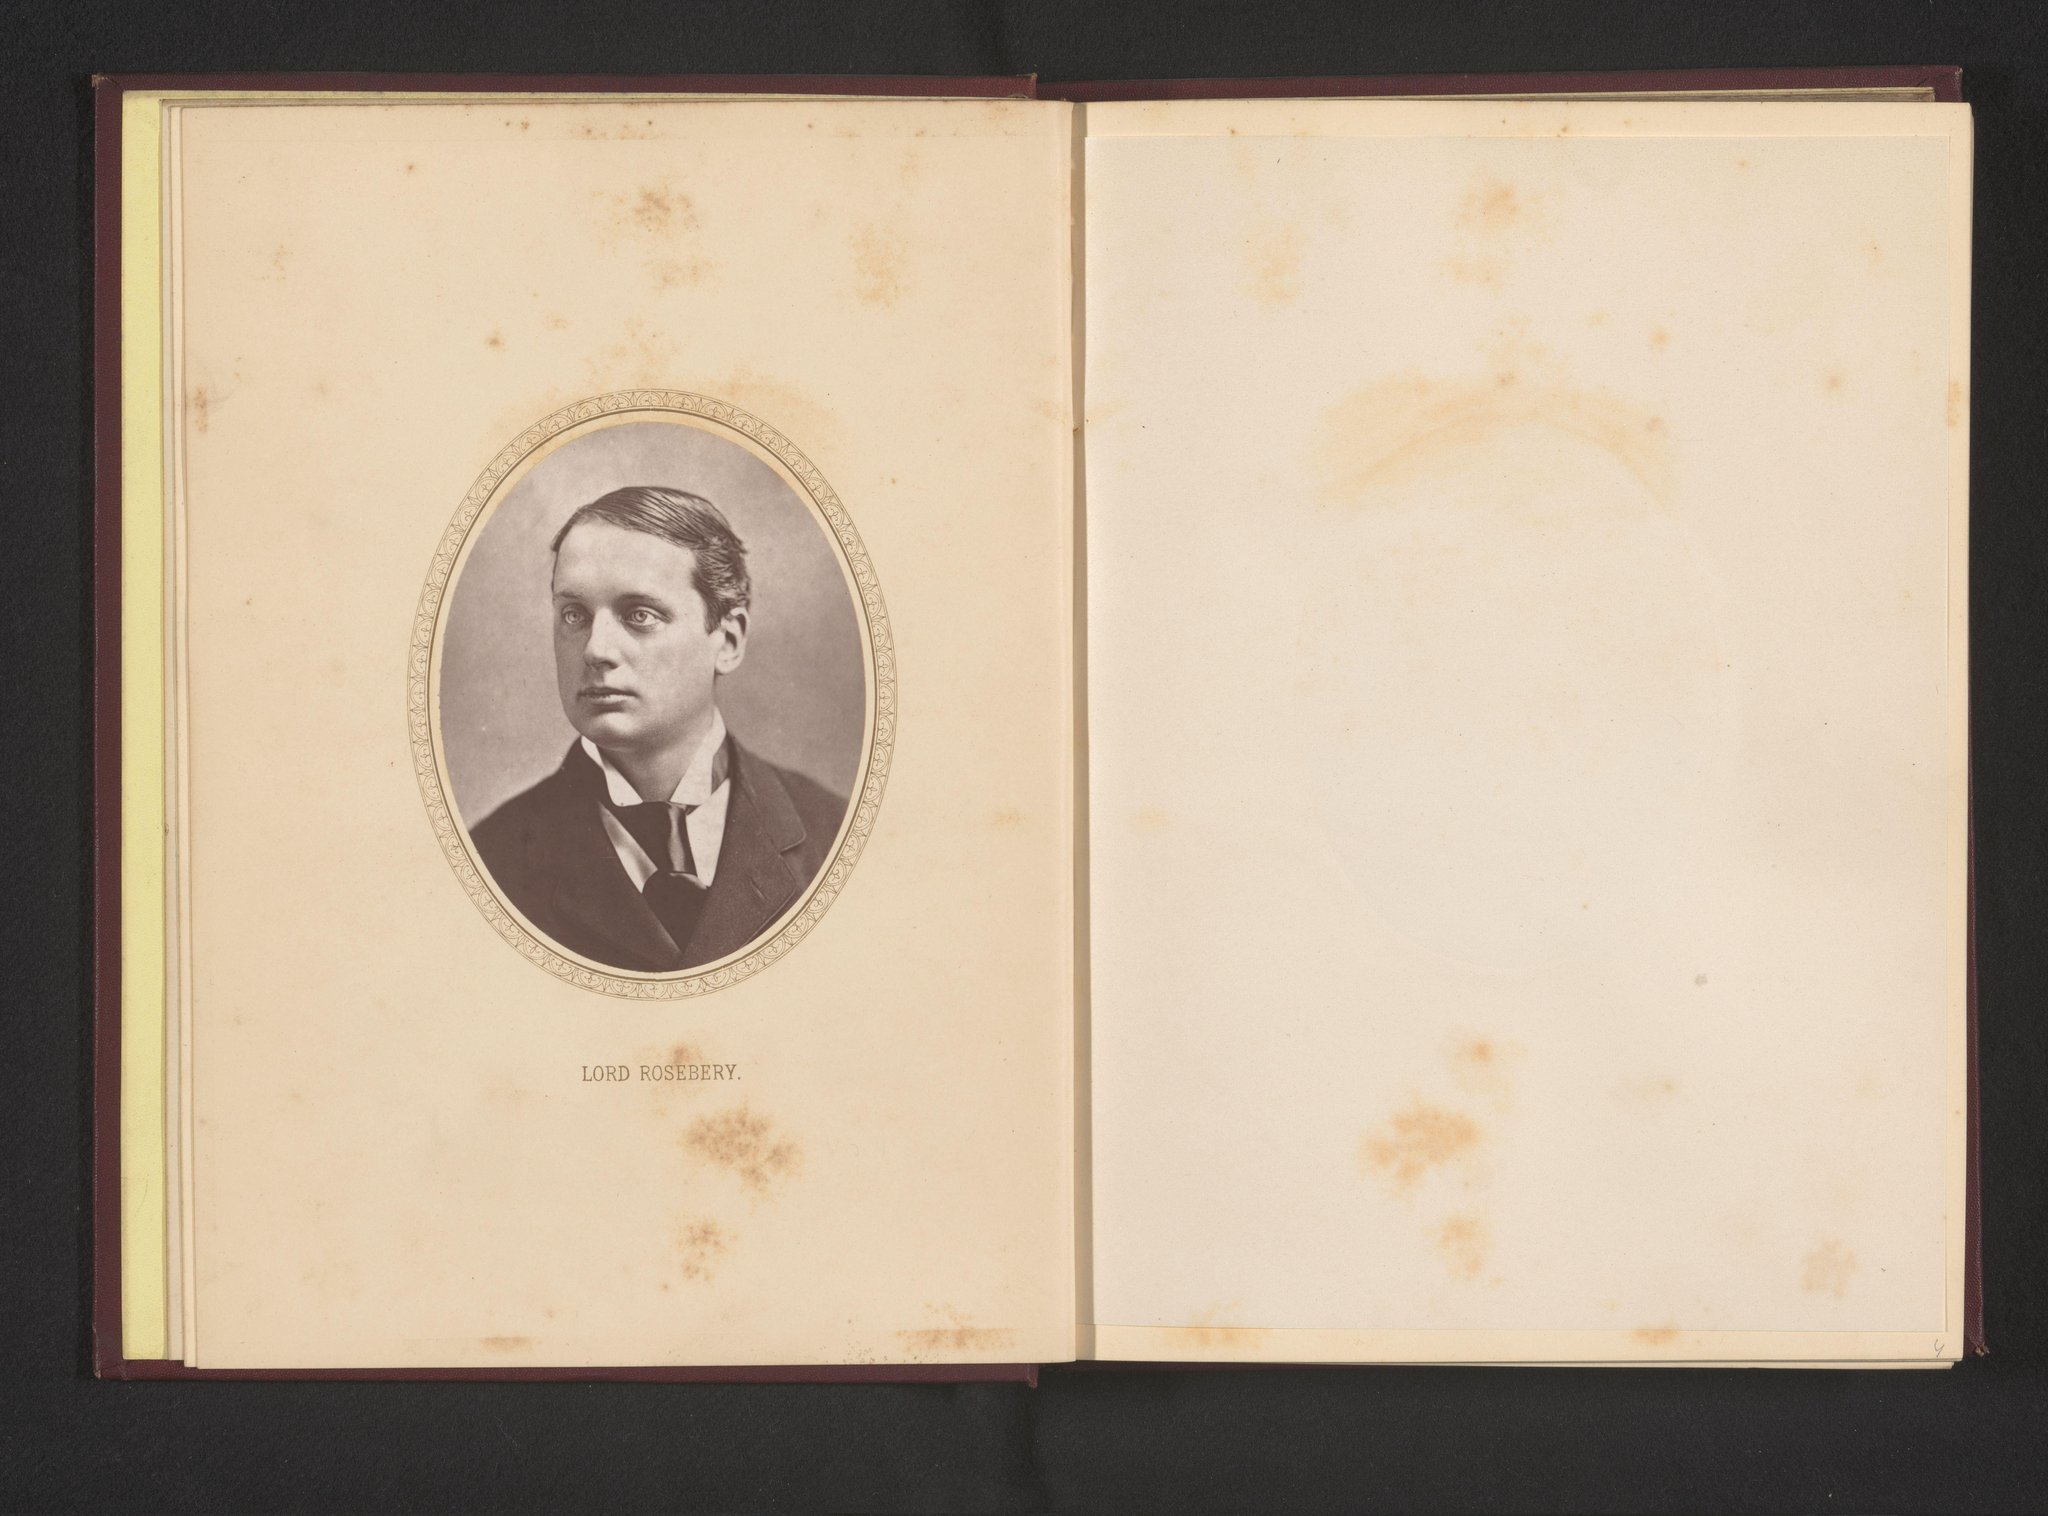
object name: photomechanical print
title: Lord Rosebery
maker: Anonymous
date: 1877-1882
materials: paper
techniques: woodburytype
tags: politician, e.g. party leader